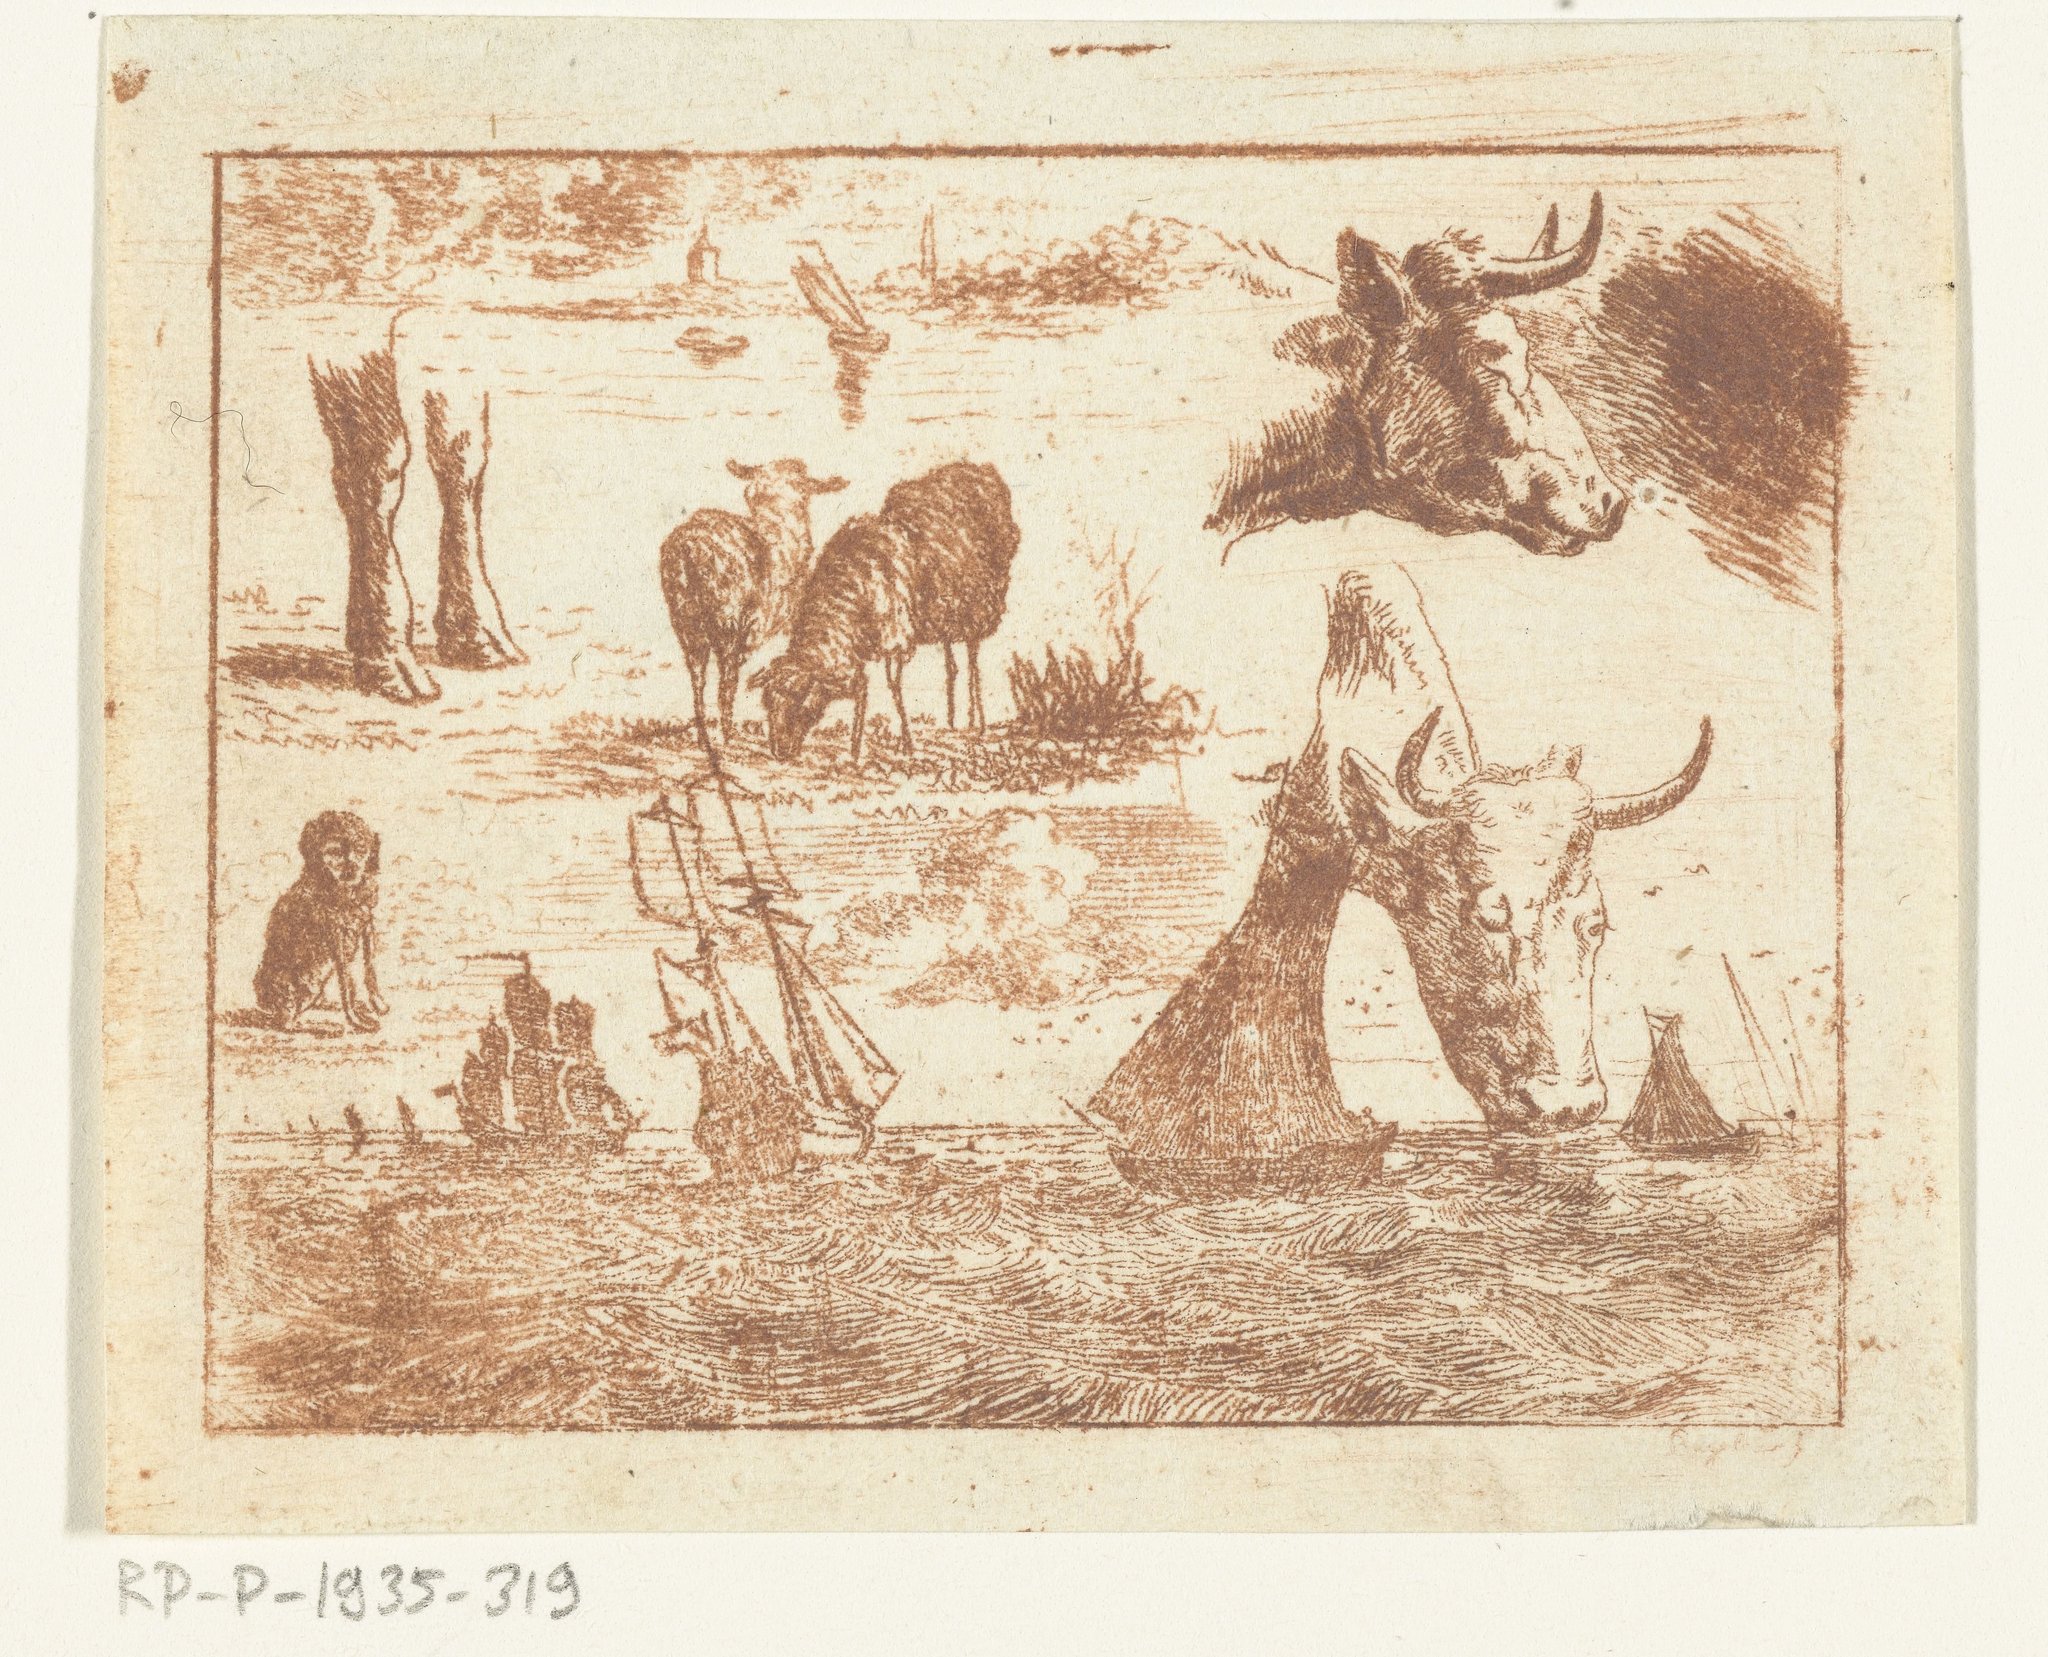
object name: print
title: Studieblad met een zeegezicht, twee koeienkoppen, schapen, een hond en twee poten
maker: ernst willem jan bagelaar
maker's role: draughtsman, print maker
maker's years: 1775-1837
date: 1798-1837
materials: paper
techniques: etching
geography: netherlands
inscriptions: collector's mark: Lugt 2228, collector's mark: Lugt 2760